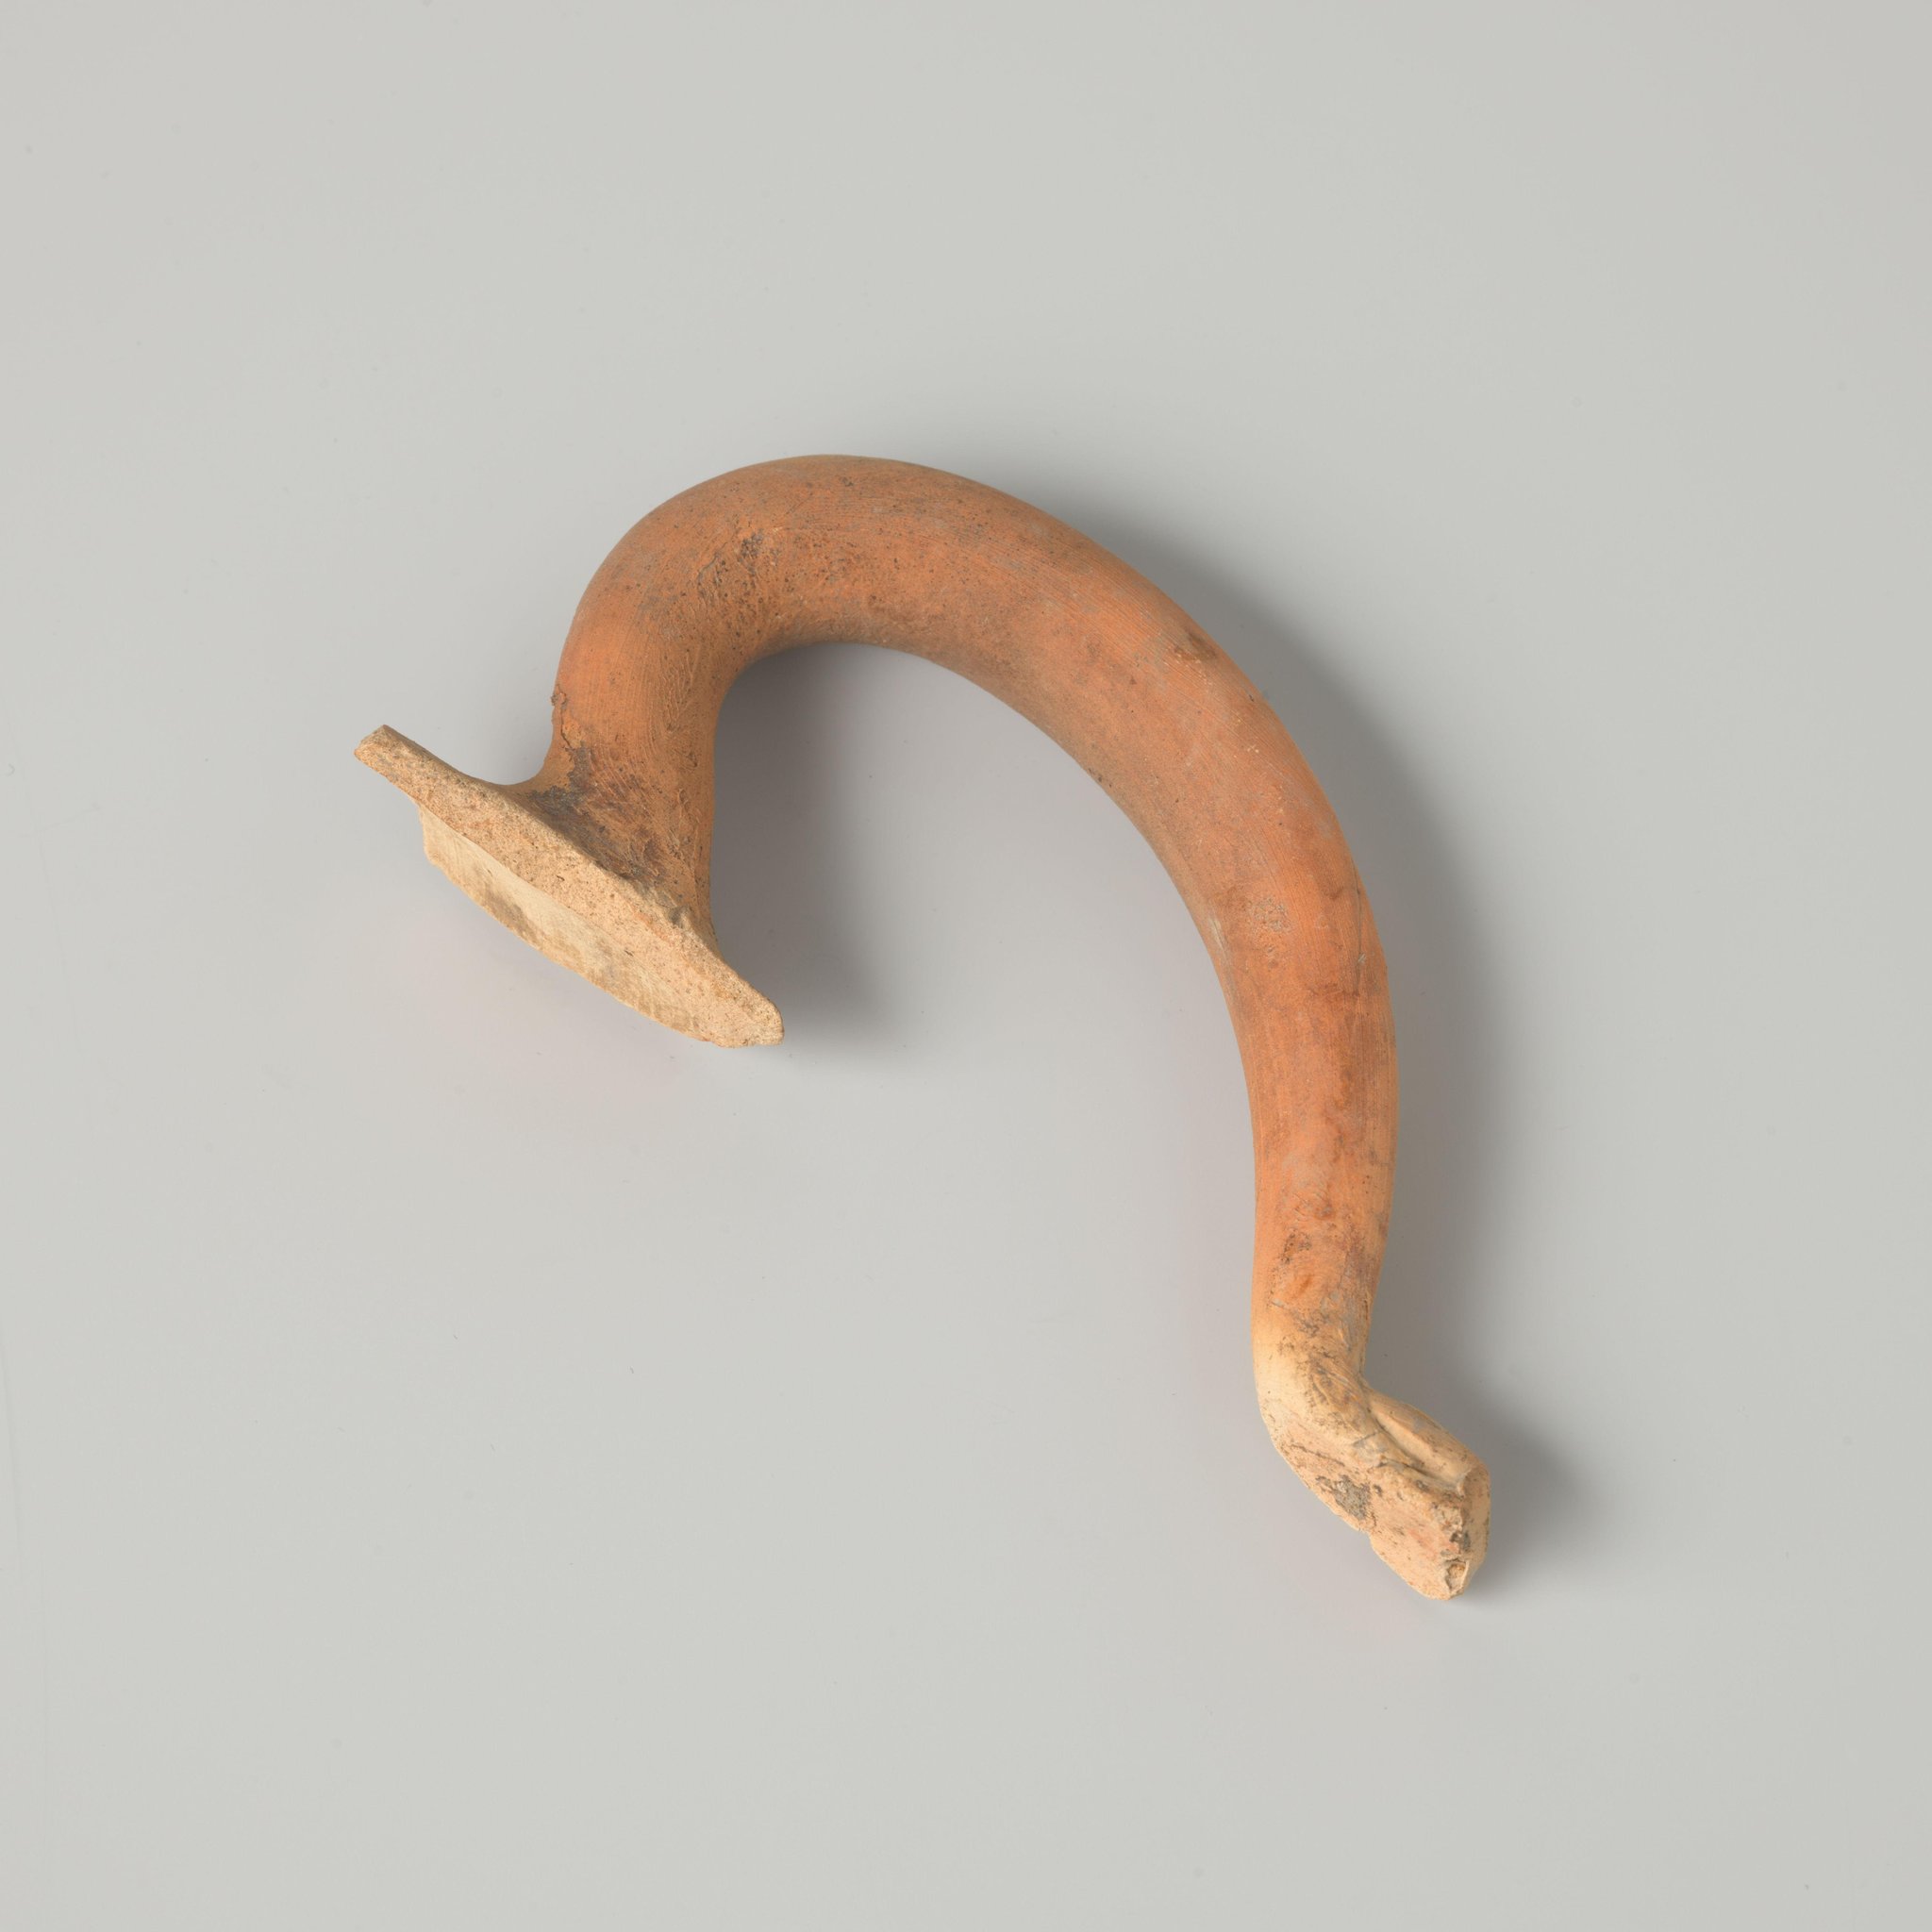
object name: bakafval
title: Oor van een kan (De Caluwe bakafval)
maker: jacobus de caluwe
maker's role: plateelbakkerij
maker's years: -1730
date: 1700-1725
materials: earthenware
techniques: firing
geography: delft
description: Toegeschreven aan Jacobus de Caluwe, omdat dit voorwerp samen met gemerkte stukken (‘Jacobus De Caluwe’ en rennend hert) gevonden is op de plaats waar zich De Caluwes tweede werkplaats bevond. Er is een duidelijke stilistische overeenkomst tussen de gemerkte en niet gemerkte voorwerpen uit deze archeologische vondst.